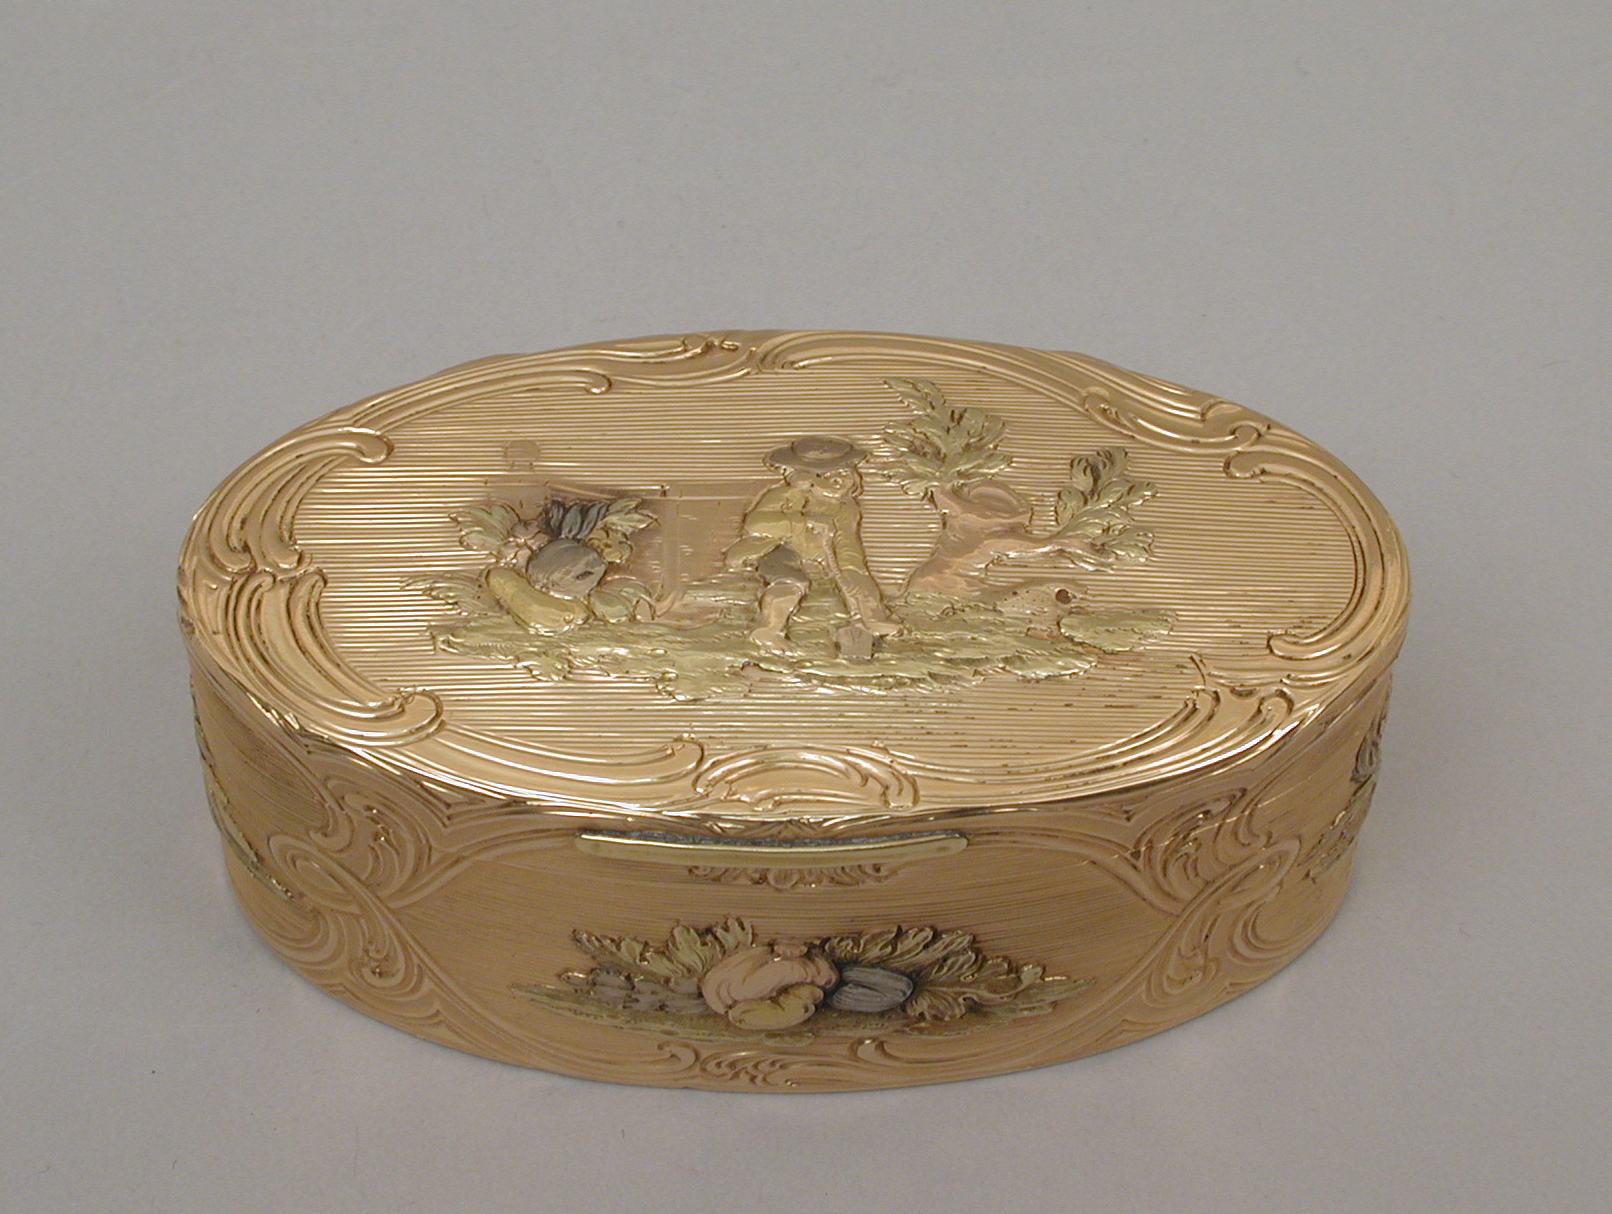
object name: snuffbox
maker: les frères toussaint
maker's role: maker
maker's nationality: french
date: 1770-1780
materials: gold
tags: men,trees